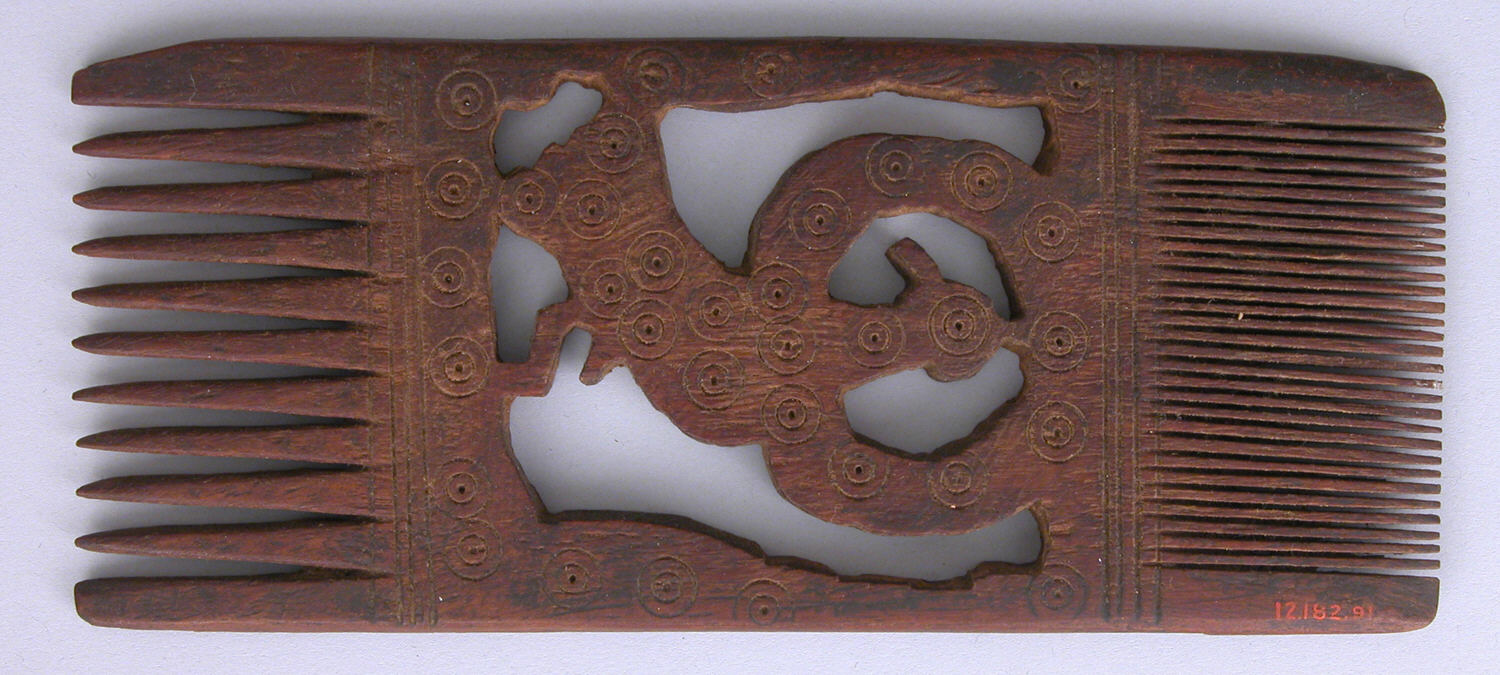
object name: comb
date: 601-800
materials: wood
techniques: carving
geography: egypt